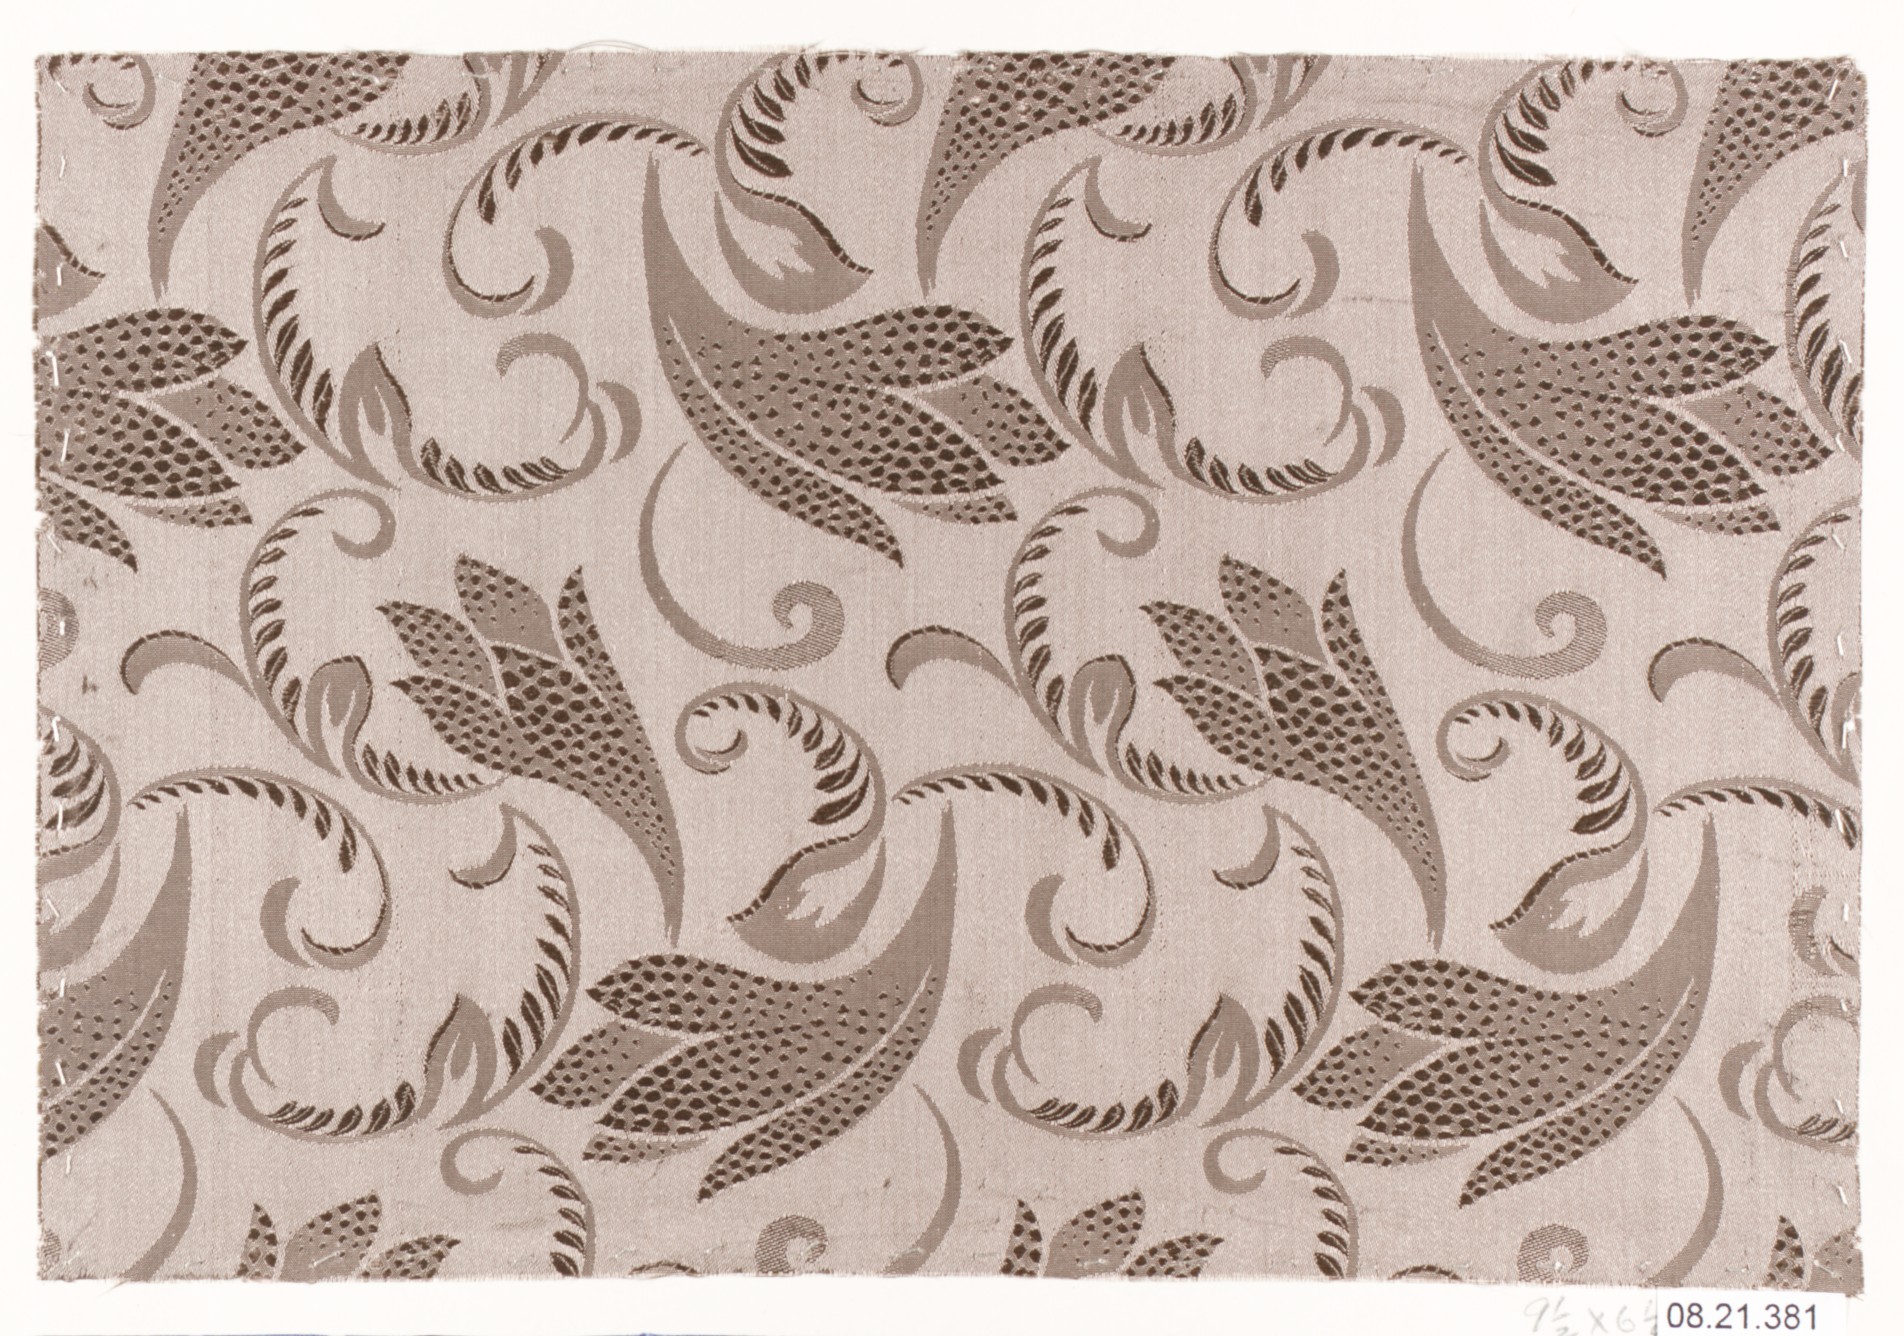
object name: textile sample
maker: Anonymous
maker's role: designer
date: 1900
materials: silk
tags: flowers